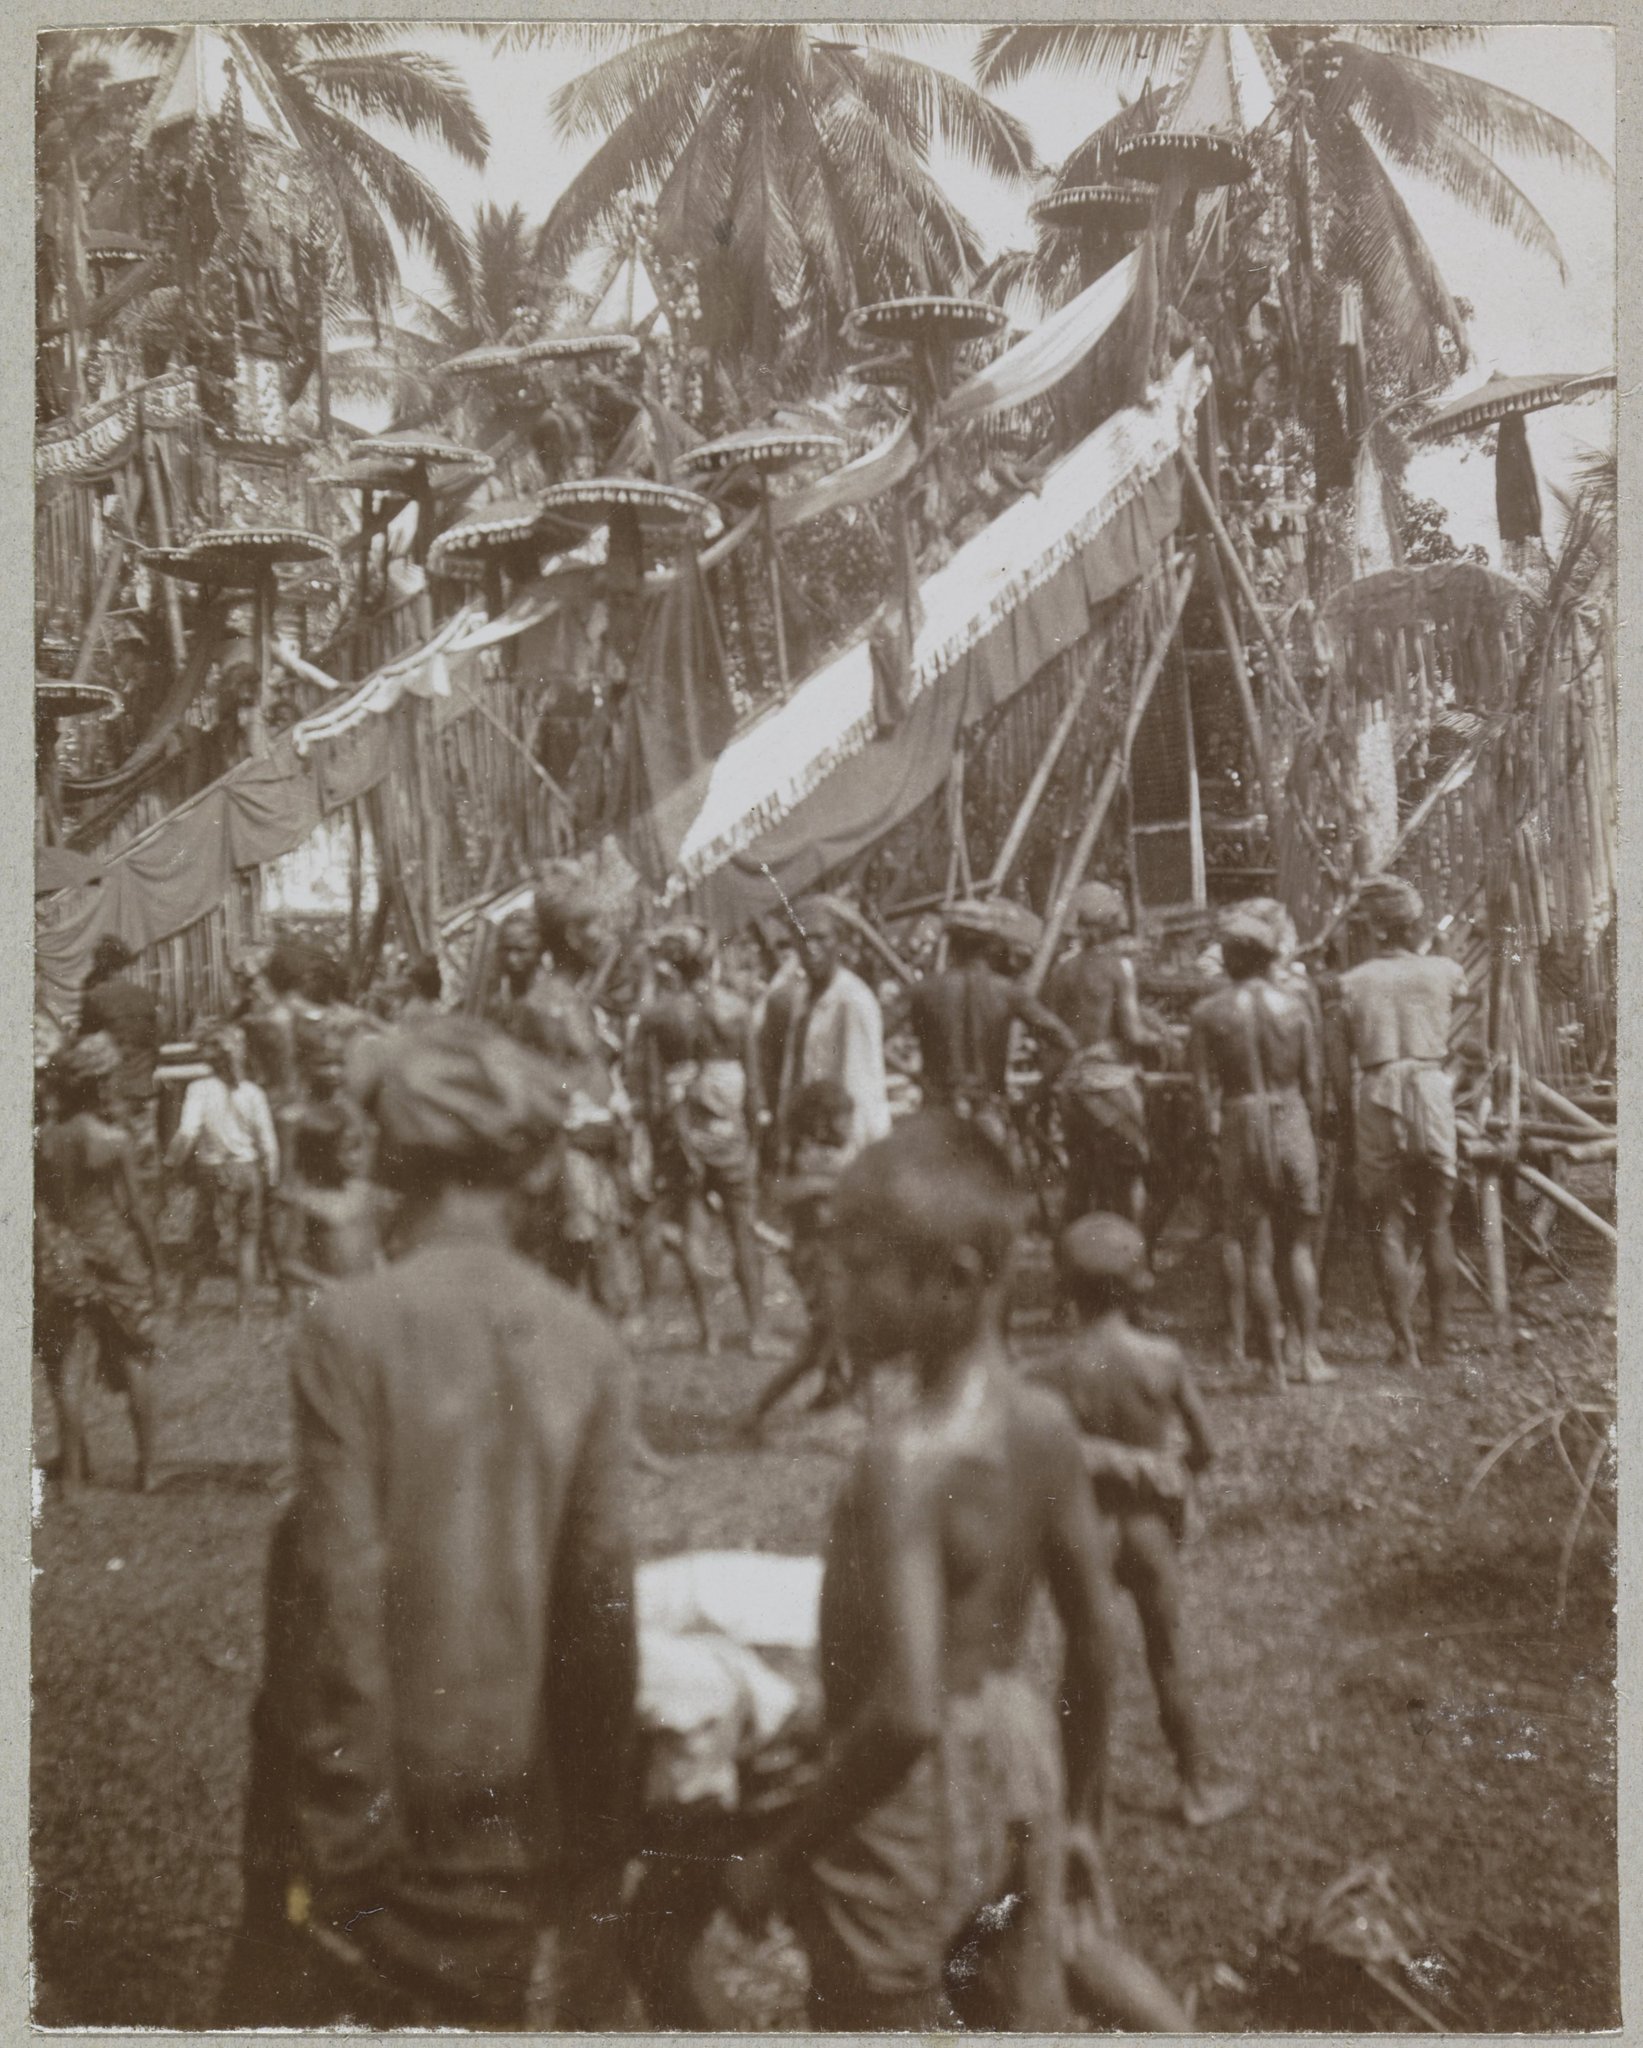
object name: photograph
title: Lijkverbrandingsfeesten, Bali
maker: Anonymous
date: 1910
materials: cardboard, paper, photographic support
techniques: collodion silver print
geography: bali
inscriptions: annotation: ‘2_3_4) lijkverbrandingsfeesten te Bali 1910.’